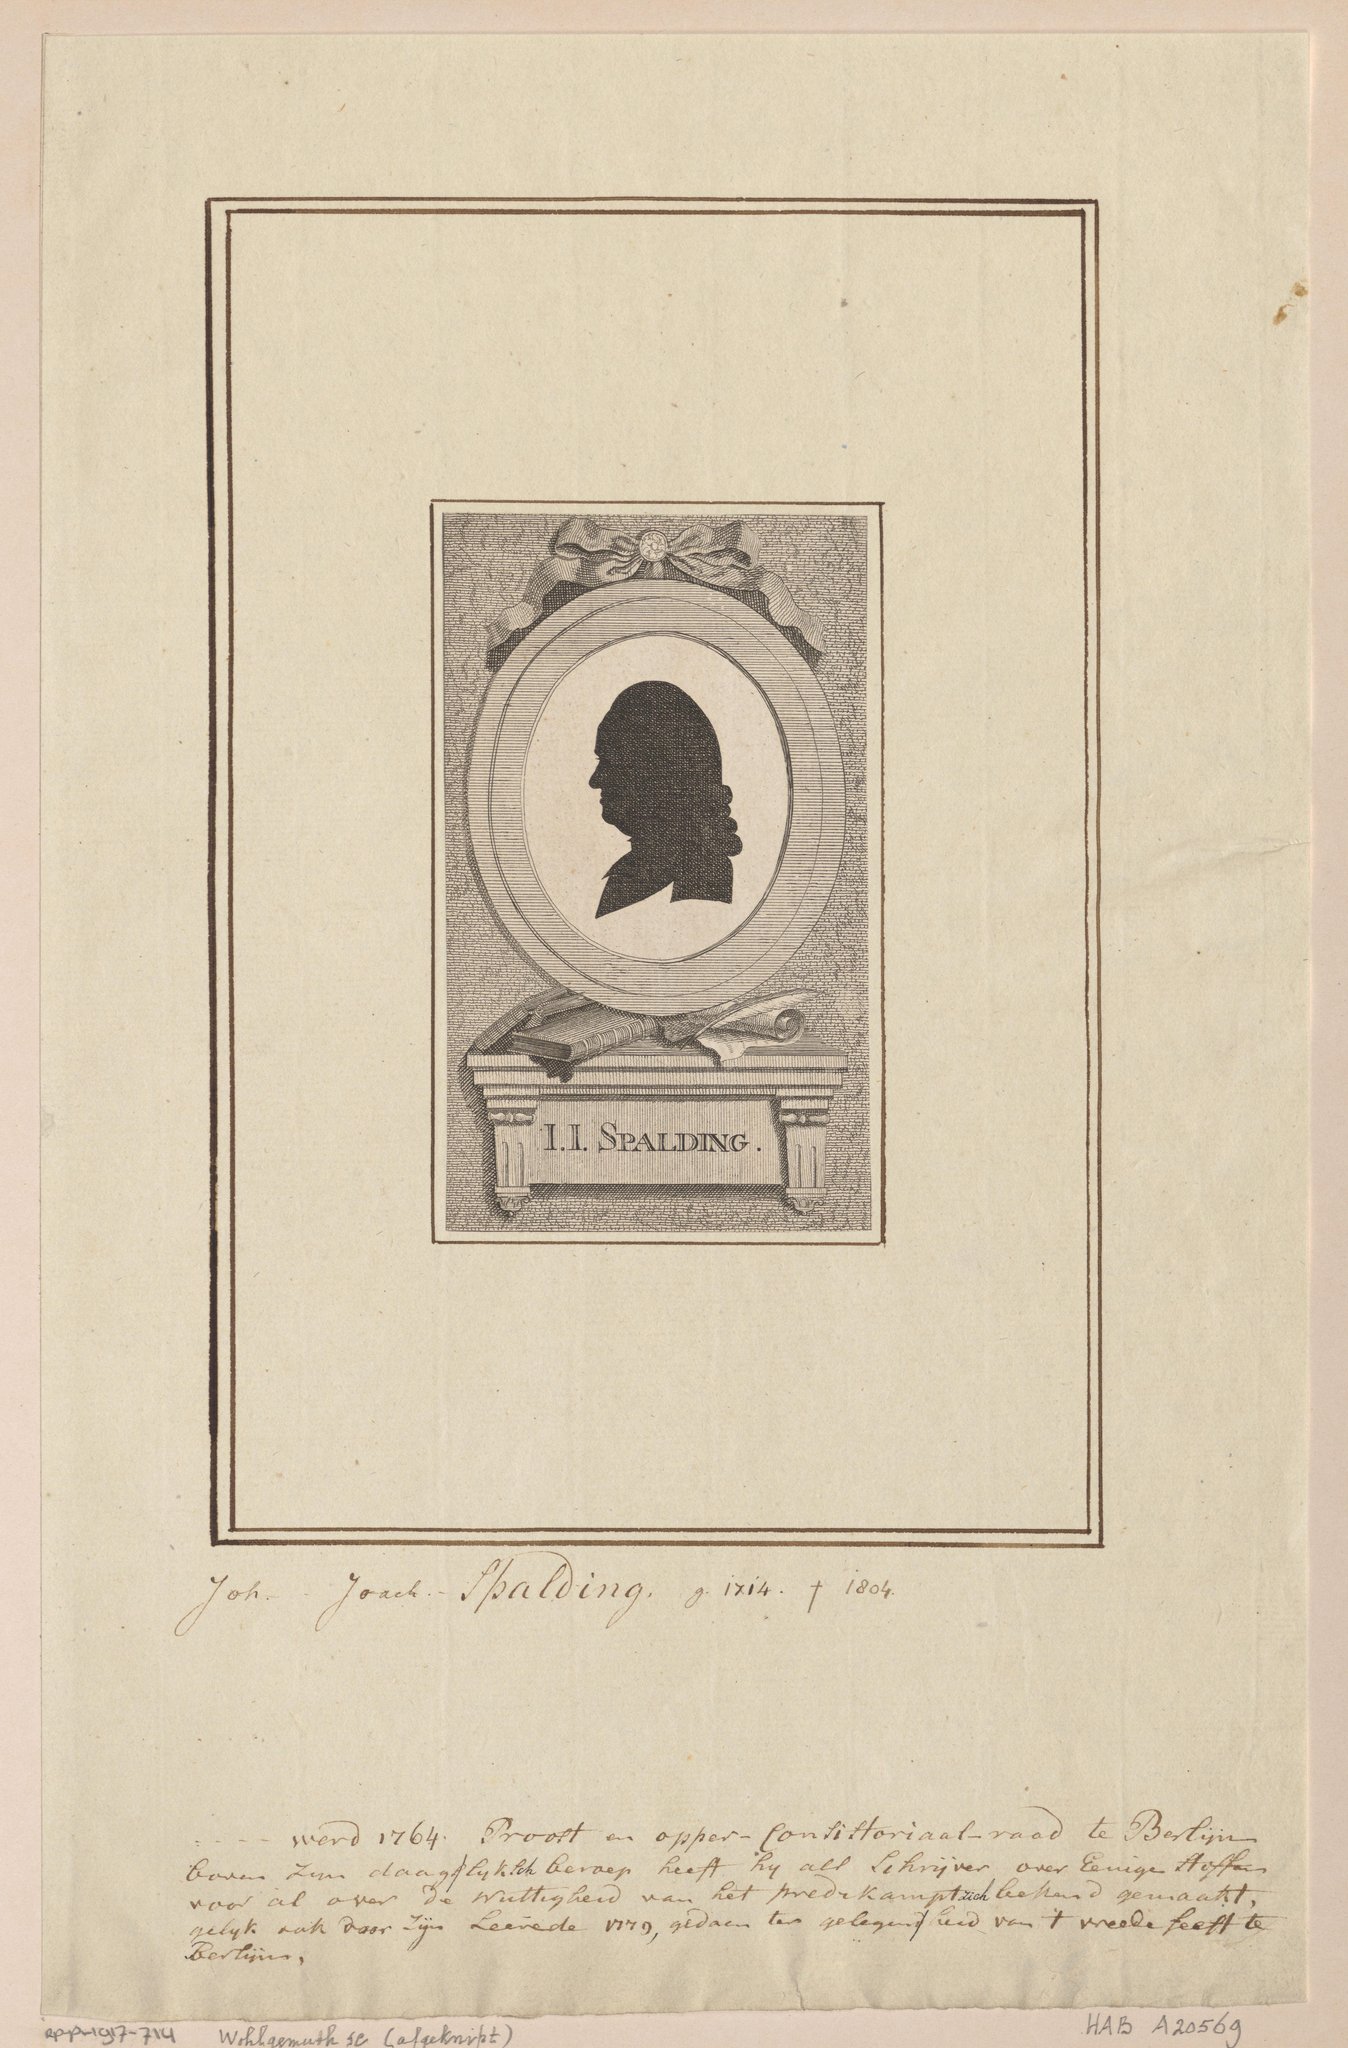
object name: silhouette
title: Silhouetportret van Johann Joachim Spalding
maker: wohlgemut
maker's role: print maker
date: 1754-1850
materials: ink, paper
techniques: etching, pen, snipping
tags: berlin, johann joachim spalding, theologian, historical persons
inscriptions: collector's mark: Lugt 2228, inscription: ‘Joh. Joachim. Spalding (...) feest te Berlijn’